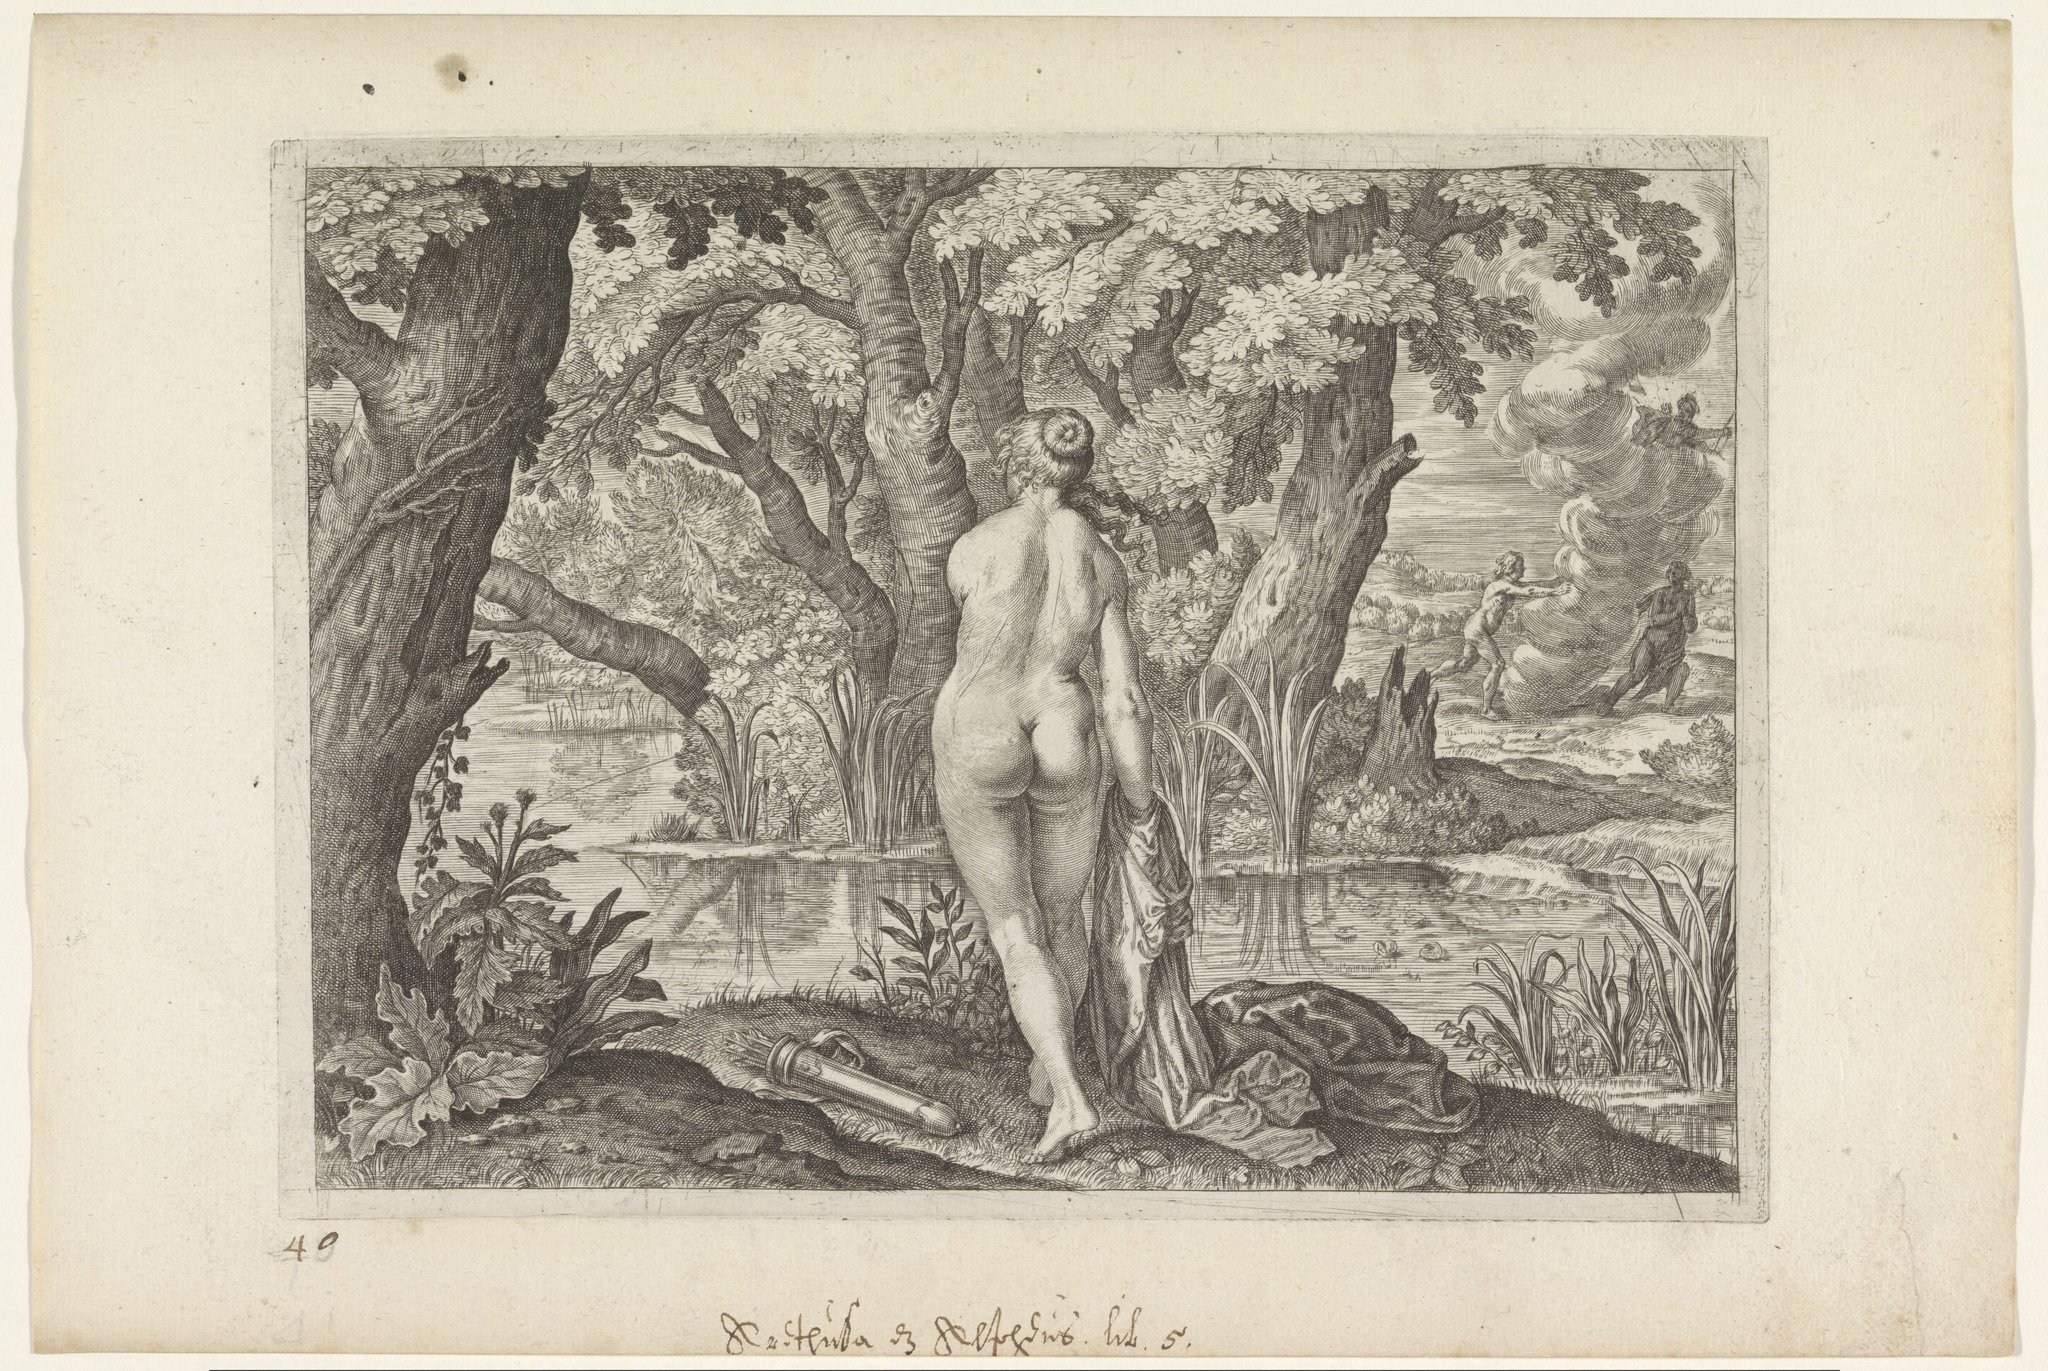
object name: print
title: Metamorfosen van Ovidius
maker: crispijn van de passe (ii)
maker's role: draughtsman, print maker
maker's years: 1594-1670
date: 1636-1670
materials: paper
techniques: engraving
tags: arethusa changed into a fountain: diana changes her attendant arethusa into a fountain, after first having hidden her in a cloud to escape alpheus, the river-god (ovid, metamorphoses v 621)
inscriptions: annotation: ‘Arethusa en Alpheus. lib. 5.’, number: ‘40’, collector's mark: ‘Hinloopen’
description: Deze incomplete serie, bestaande uit 77 van de in totaal 85 prenten met scènes uit Ovidius' Metamorfosen, werd in 1709 samen met Ovidius-illustraties van Tempesta, Goltzius en Le Pautre in één album, Schijnvoet nummer 43, ingebonden. In de negentiende eeuw werd deze band weer uit elkaar gehaald.